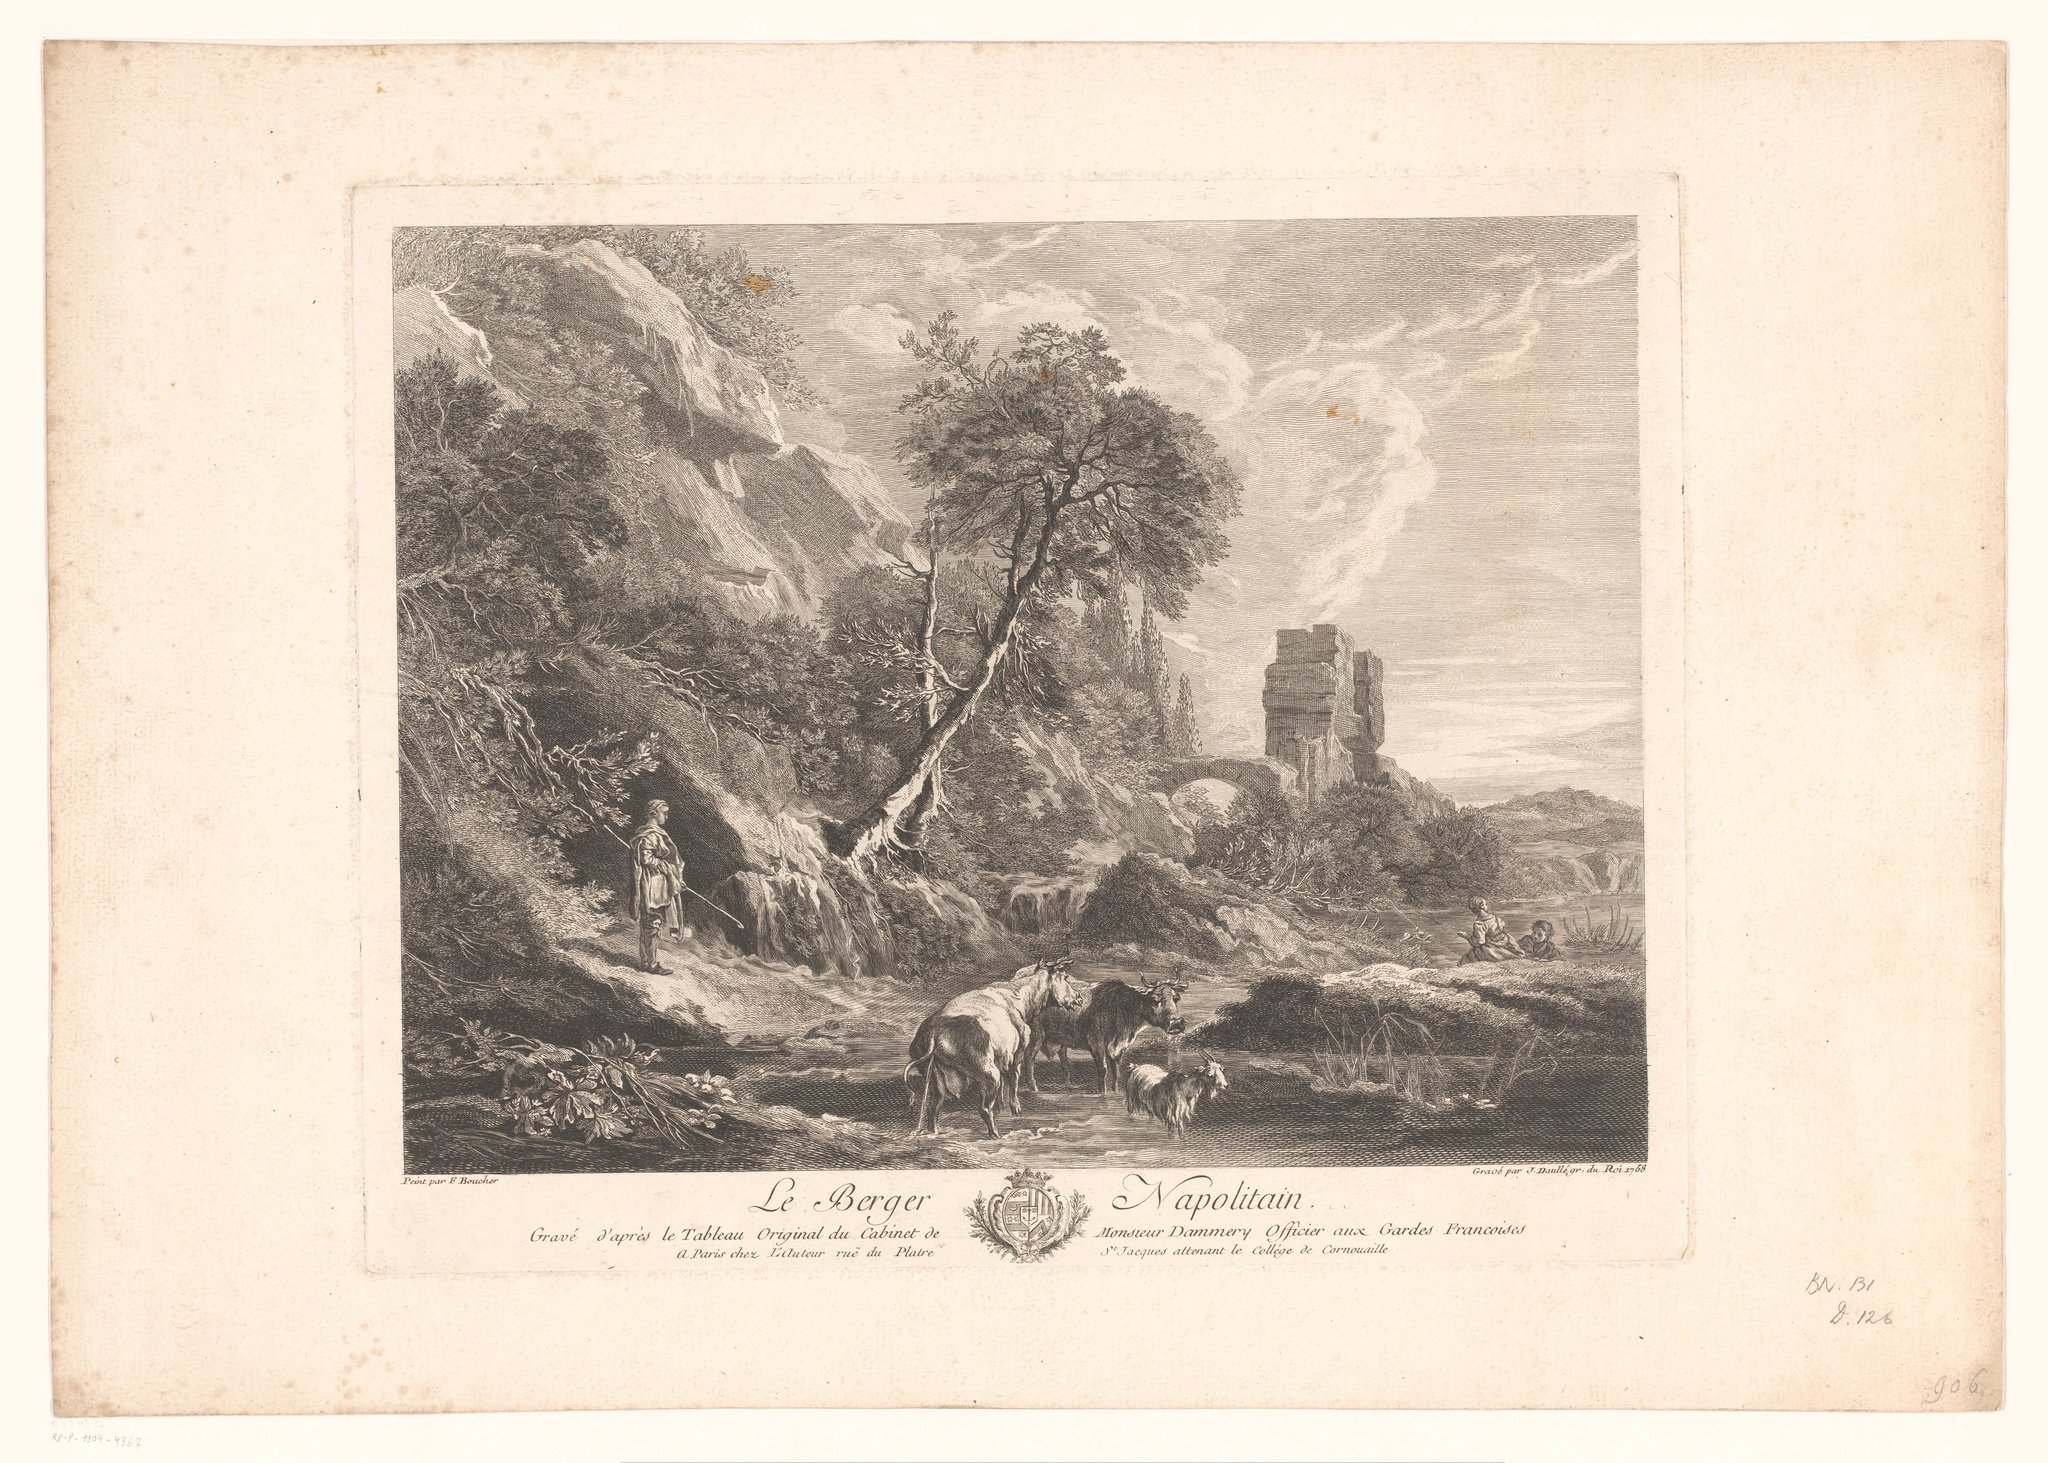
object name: print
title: Le Berger Napolitain.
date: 1758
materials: paper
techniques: engraving, etching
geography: france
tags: herding, herdsman, herdswoman, shepherd, shepherdess, cowherd, etc., landscape with ruins, herd, flock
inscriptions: collector's mark: Lugt 2228